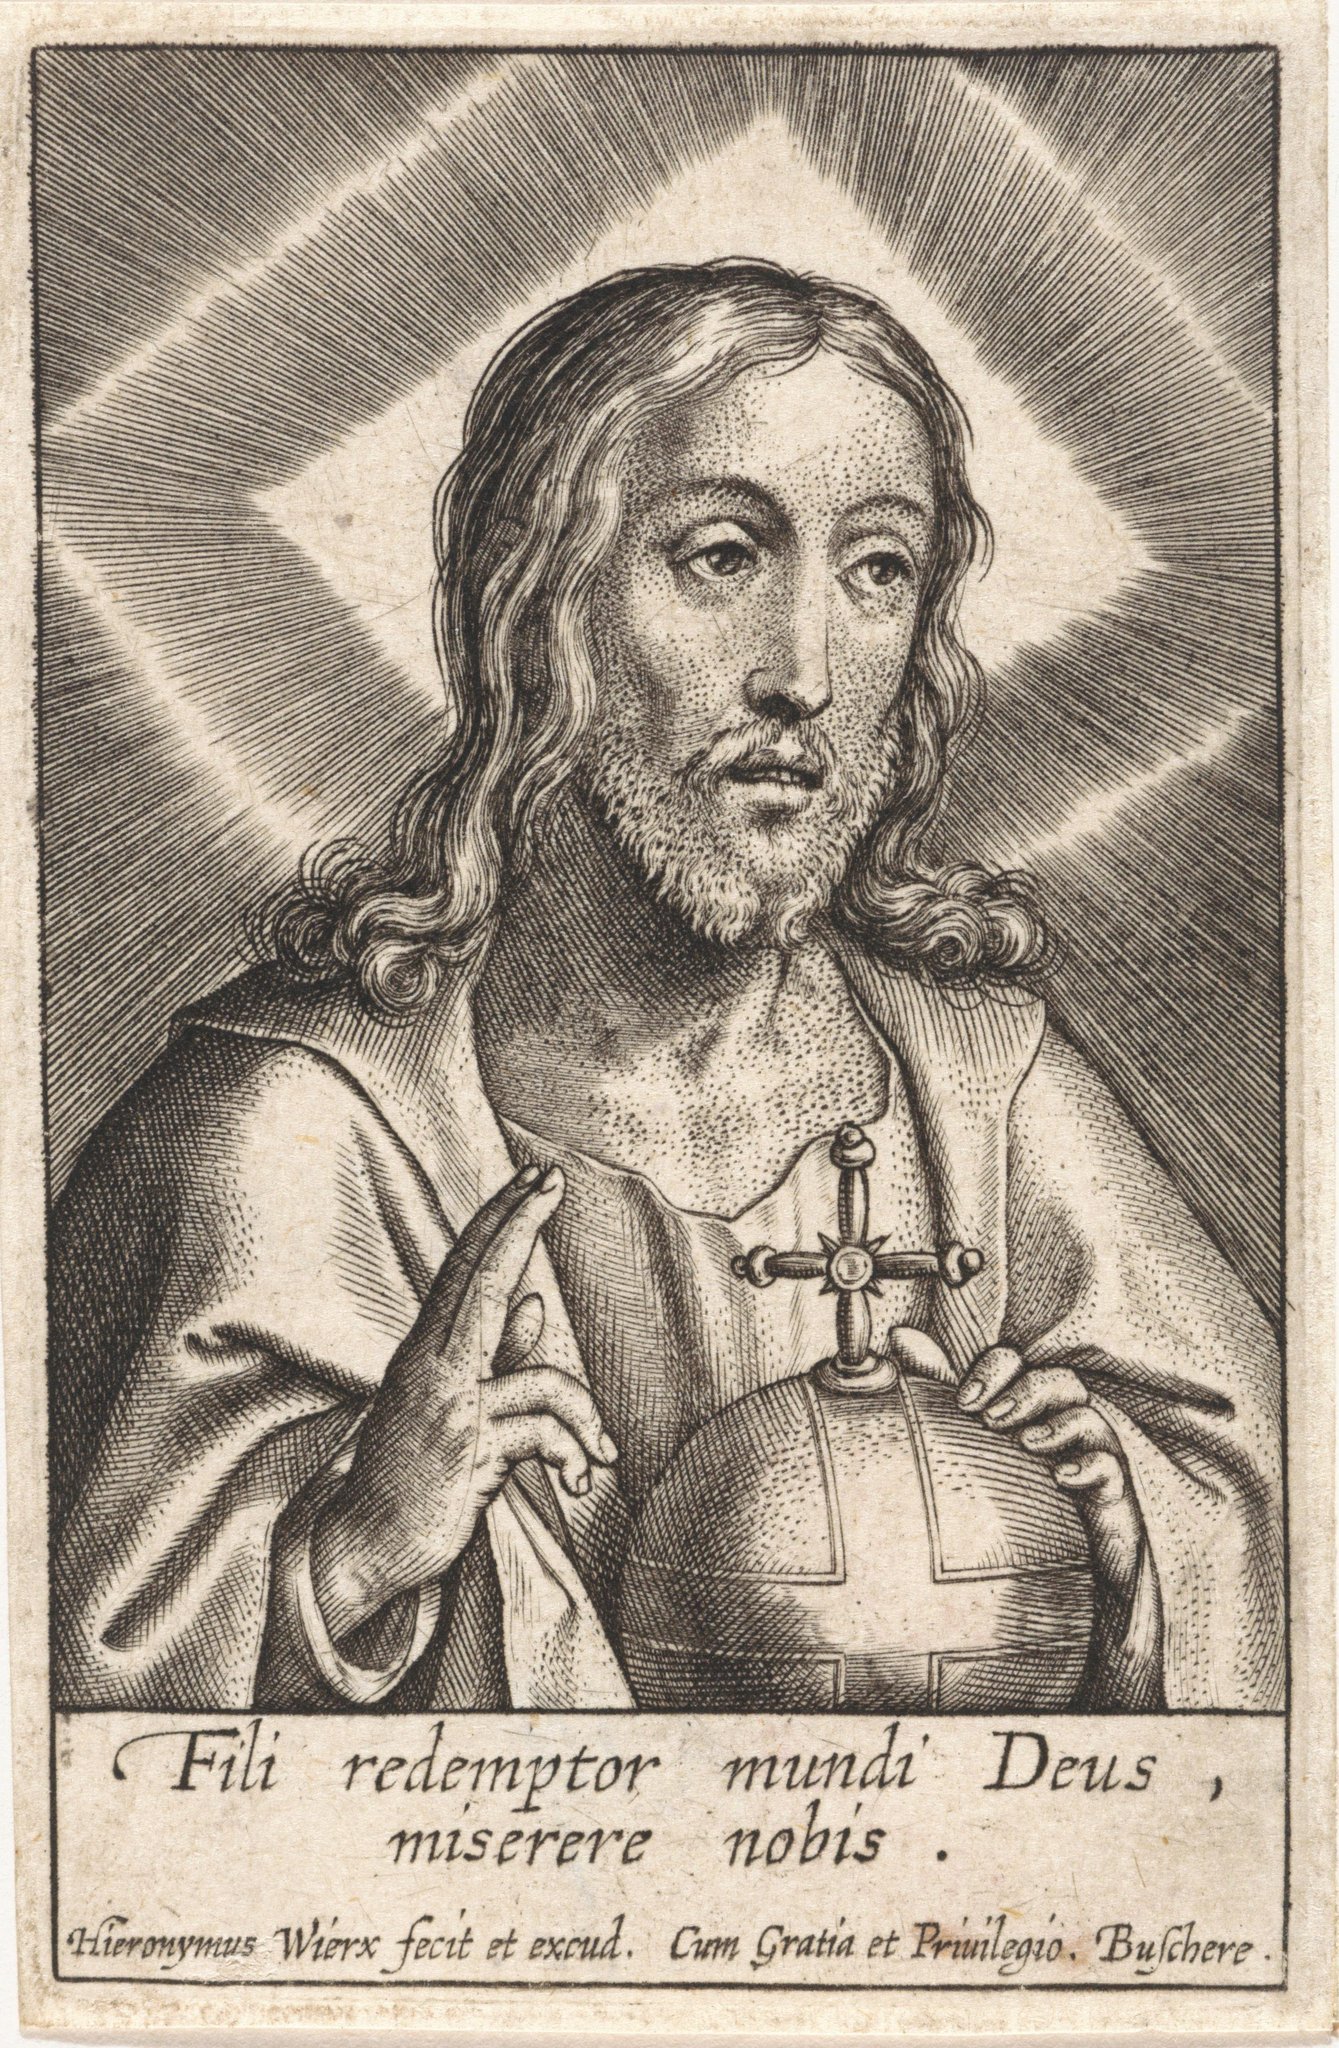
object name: print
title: Christus als Salvator Mundi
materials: paper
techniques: engraving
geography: antwerp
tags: 'salvator mundi', making a blessing gesture; an orb in his hand or at his feet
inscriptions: collector's mark: Lugt 240, number: ‘30’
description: Christus houdt een rijksappel in de ene hand, en maakt een zegenend gebaar met de ander hand. In de marge een tweeregelig onderschrift in het Latijn.